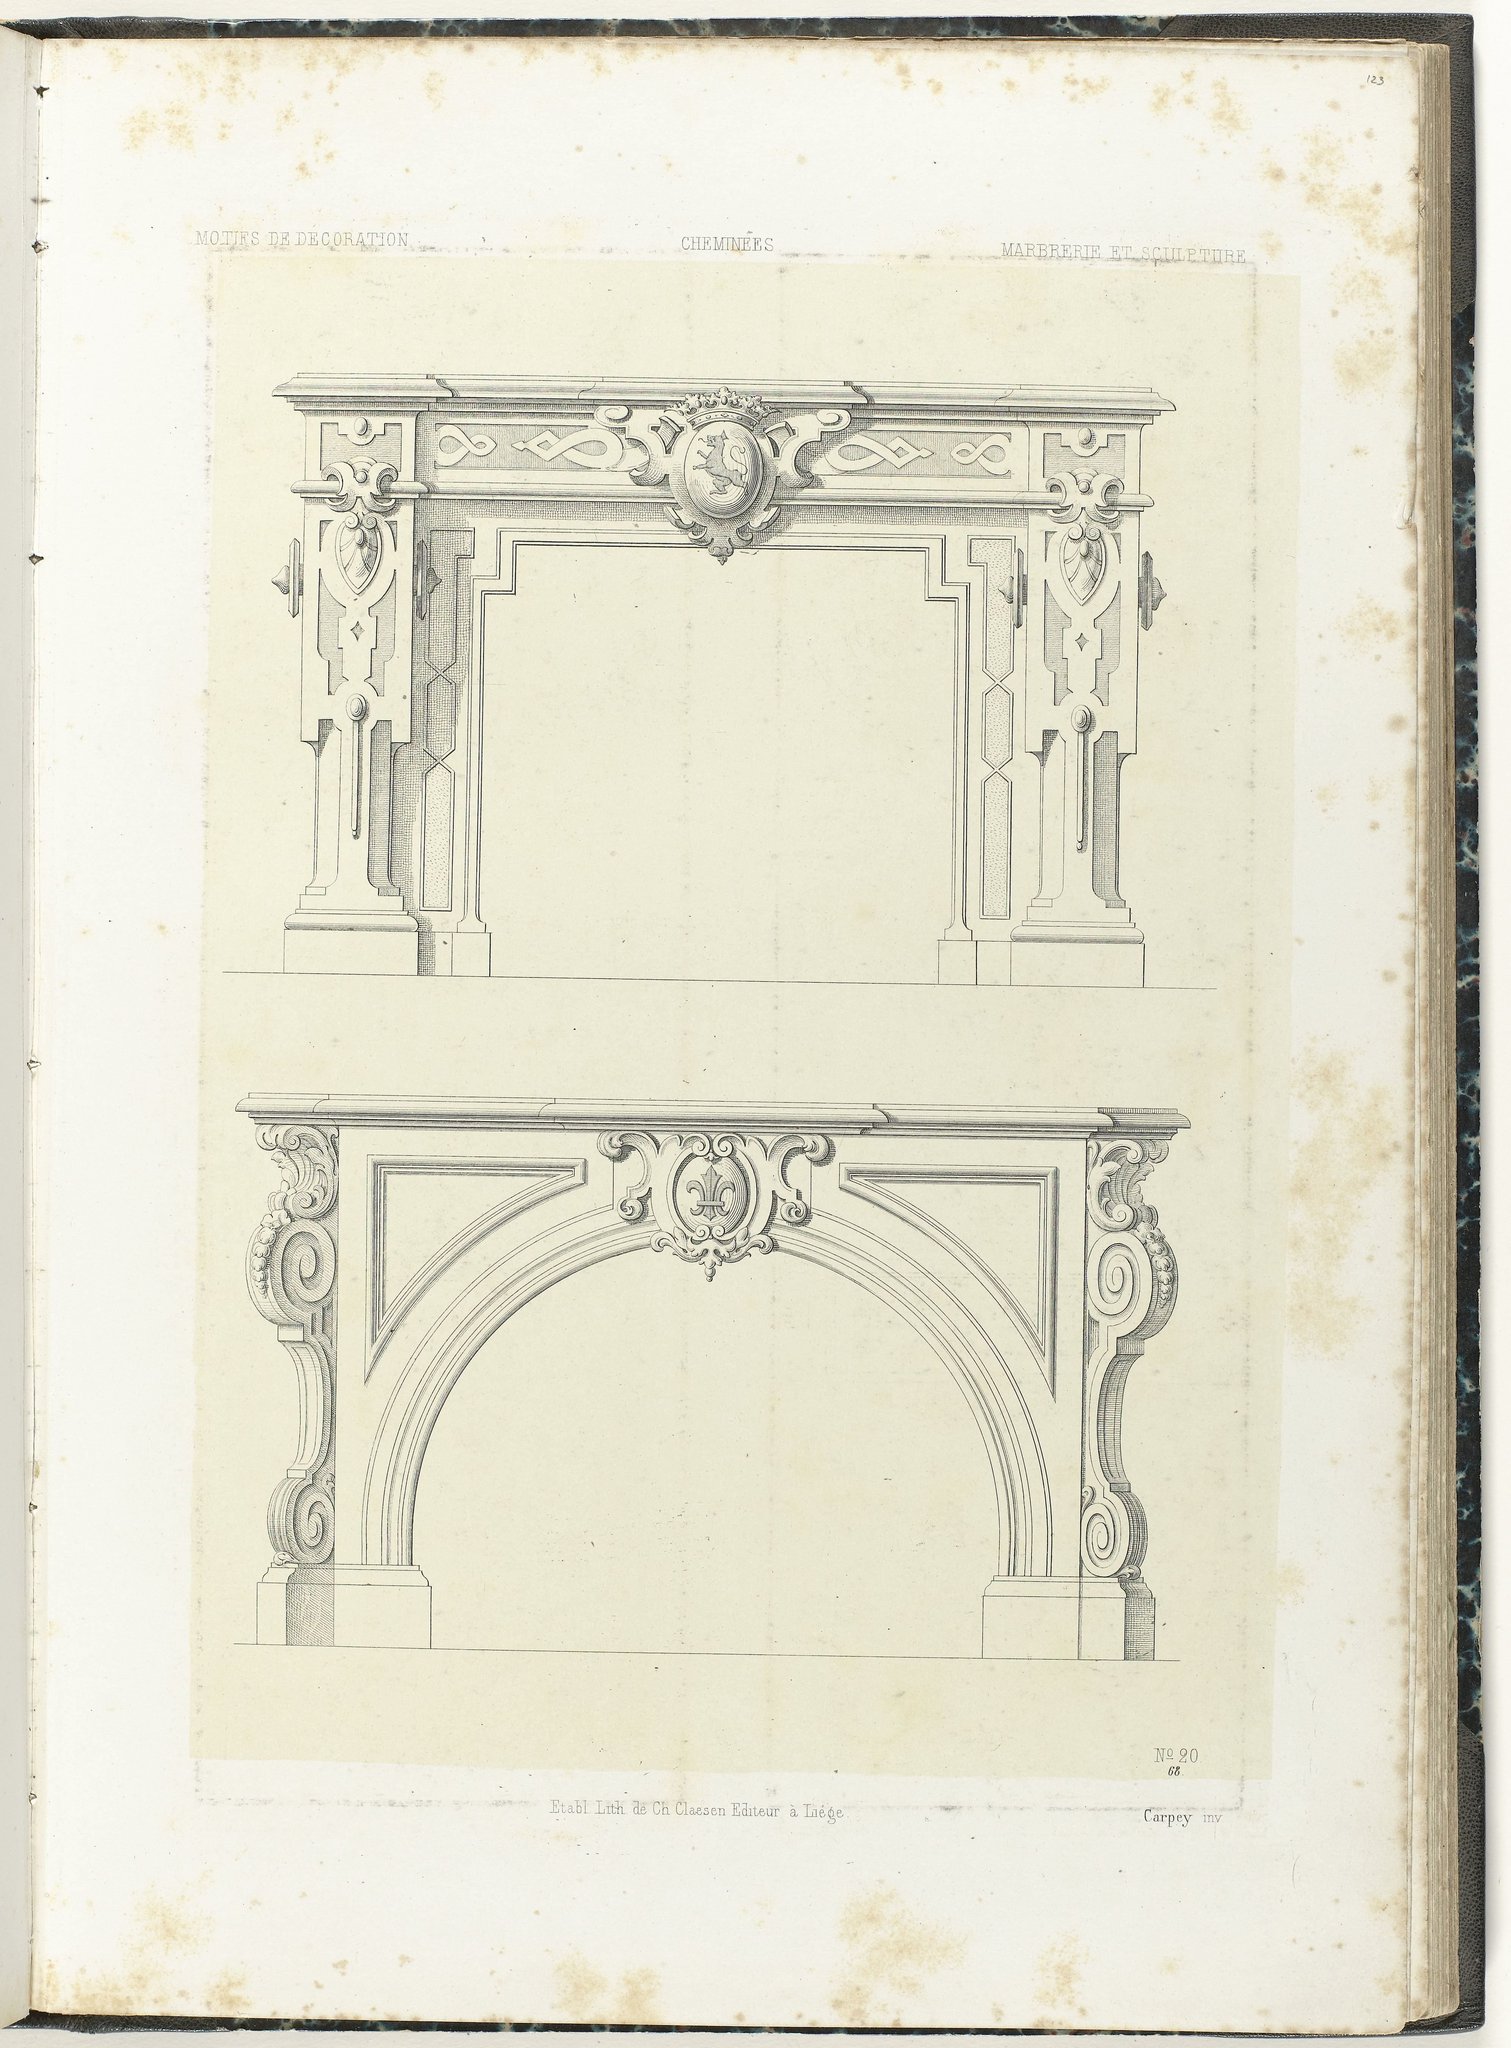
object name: print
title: Cheminées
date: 1866-1900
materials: paper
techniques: tone lithography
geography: liège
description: Onderboezem met midden boven een leeuw in een cartouche van rolwerk en onderboezem met fleur-de-lys in cartouche met bladranken. Linksboven staat: Motifs de décoration, rechtsboven: Marbrerie et sculpture, rechtsonder: N° 20. 68.